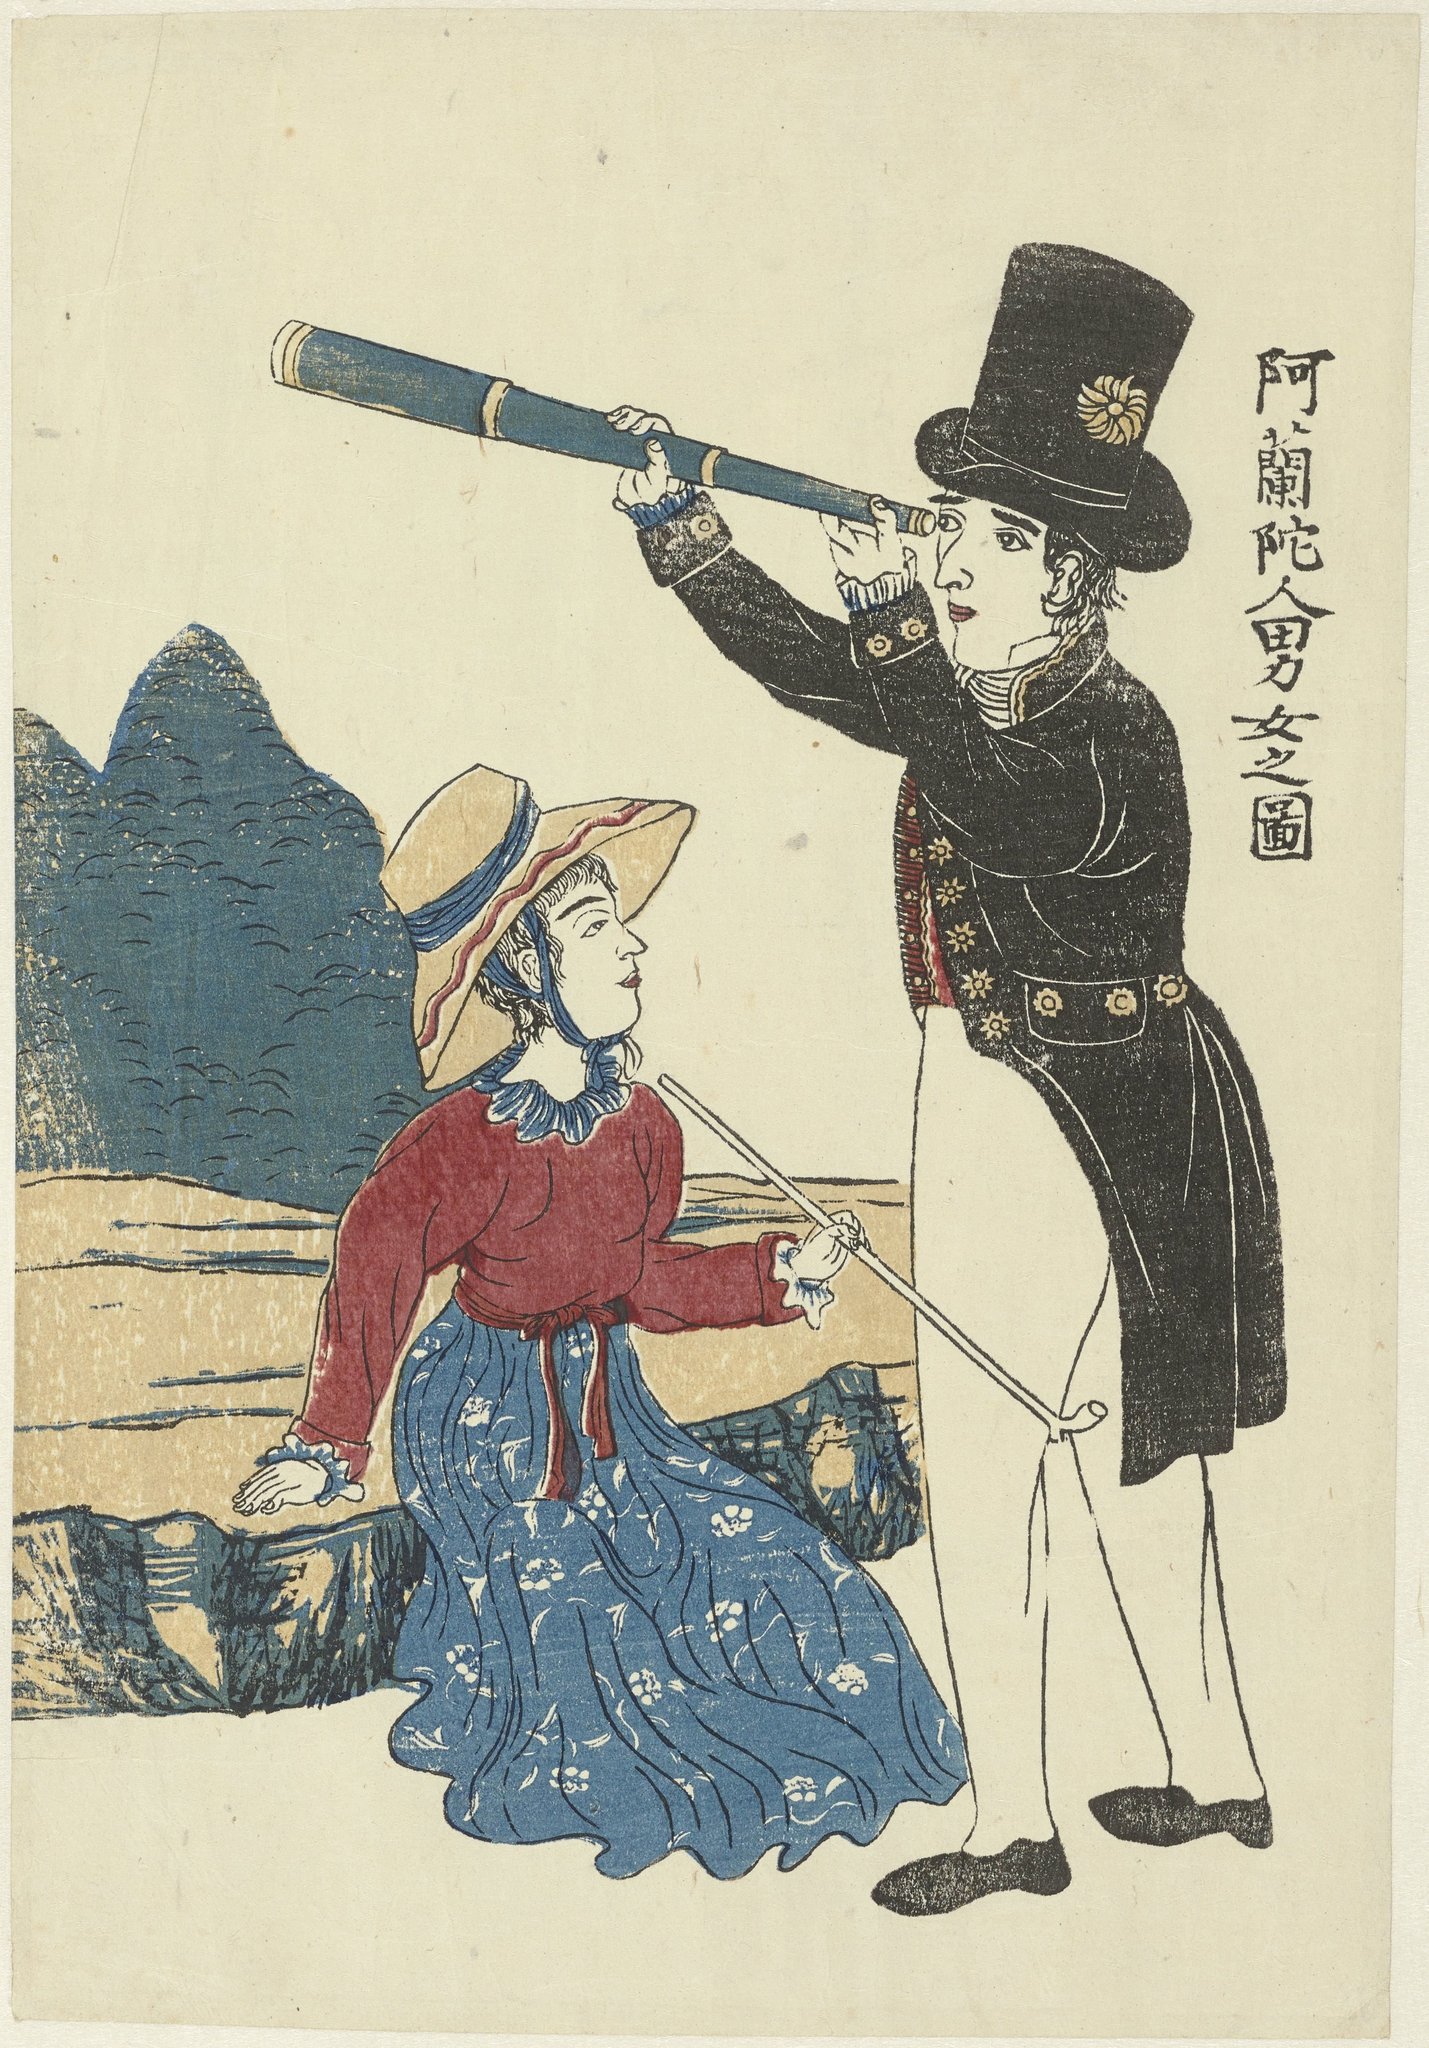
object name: print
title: Orandajin danjo no zu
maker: Anonymous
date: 1740-1864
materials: paper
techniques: woodcut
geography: nagasaki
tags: telescope, europeans (with name)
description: Een man kijkt door een telescoop, terwijl er een vrouw met een lange pijp in haar hand naast hem zit. (Nagasaki-e).